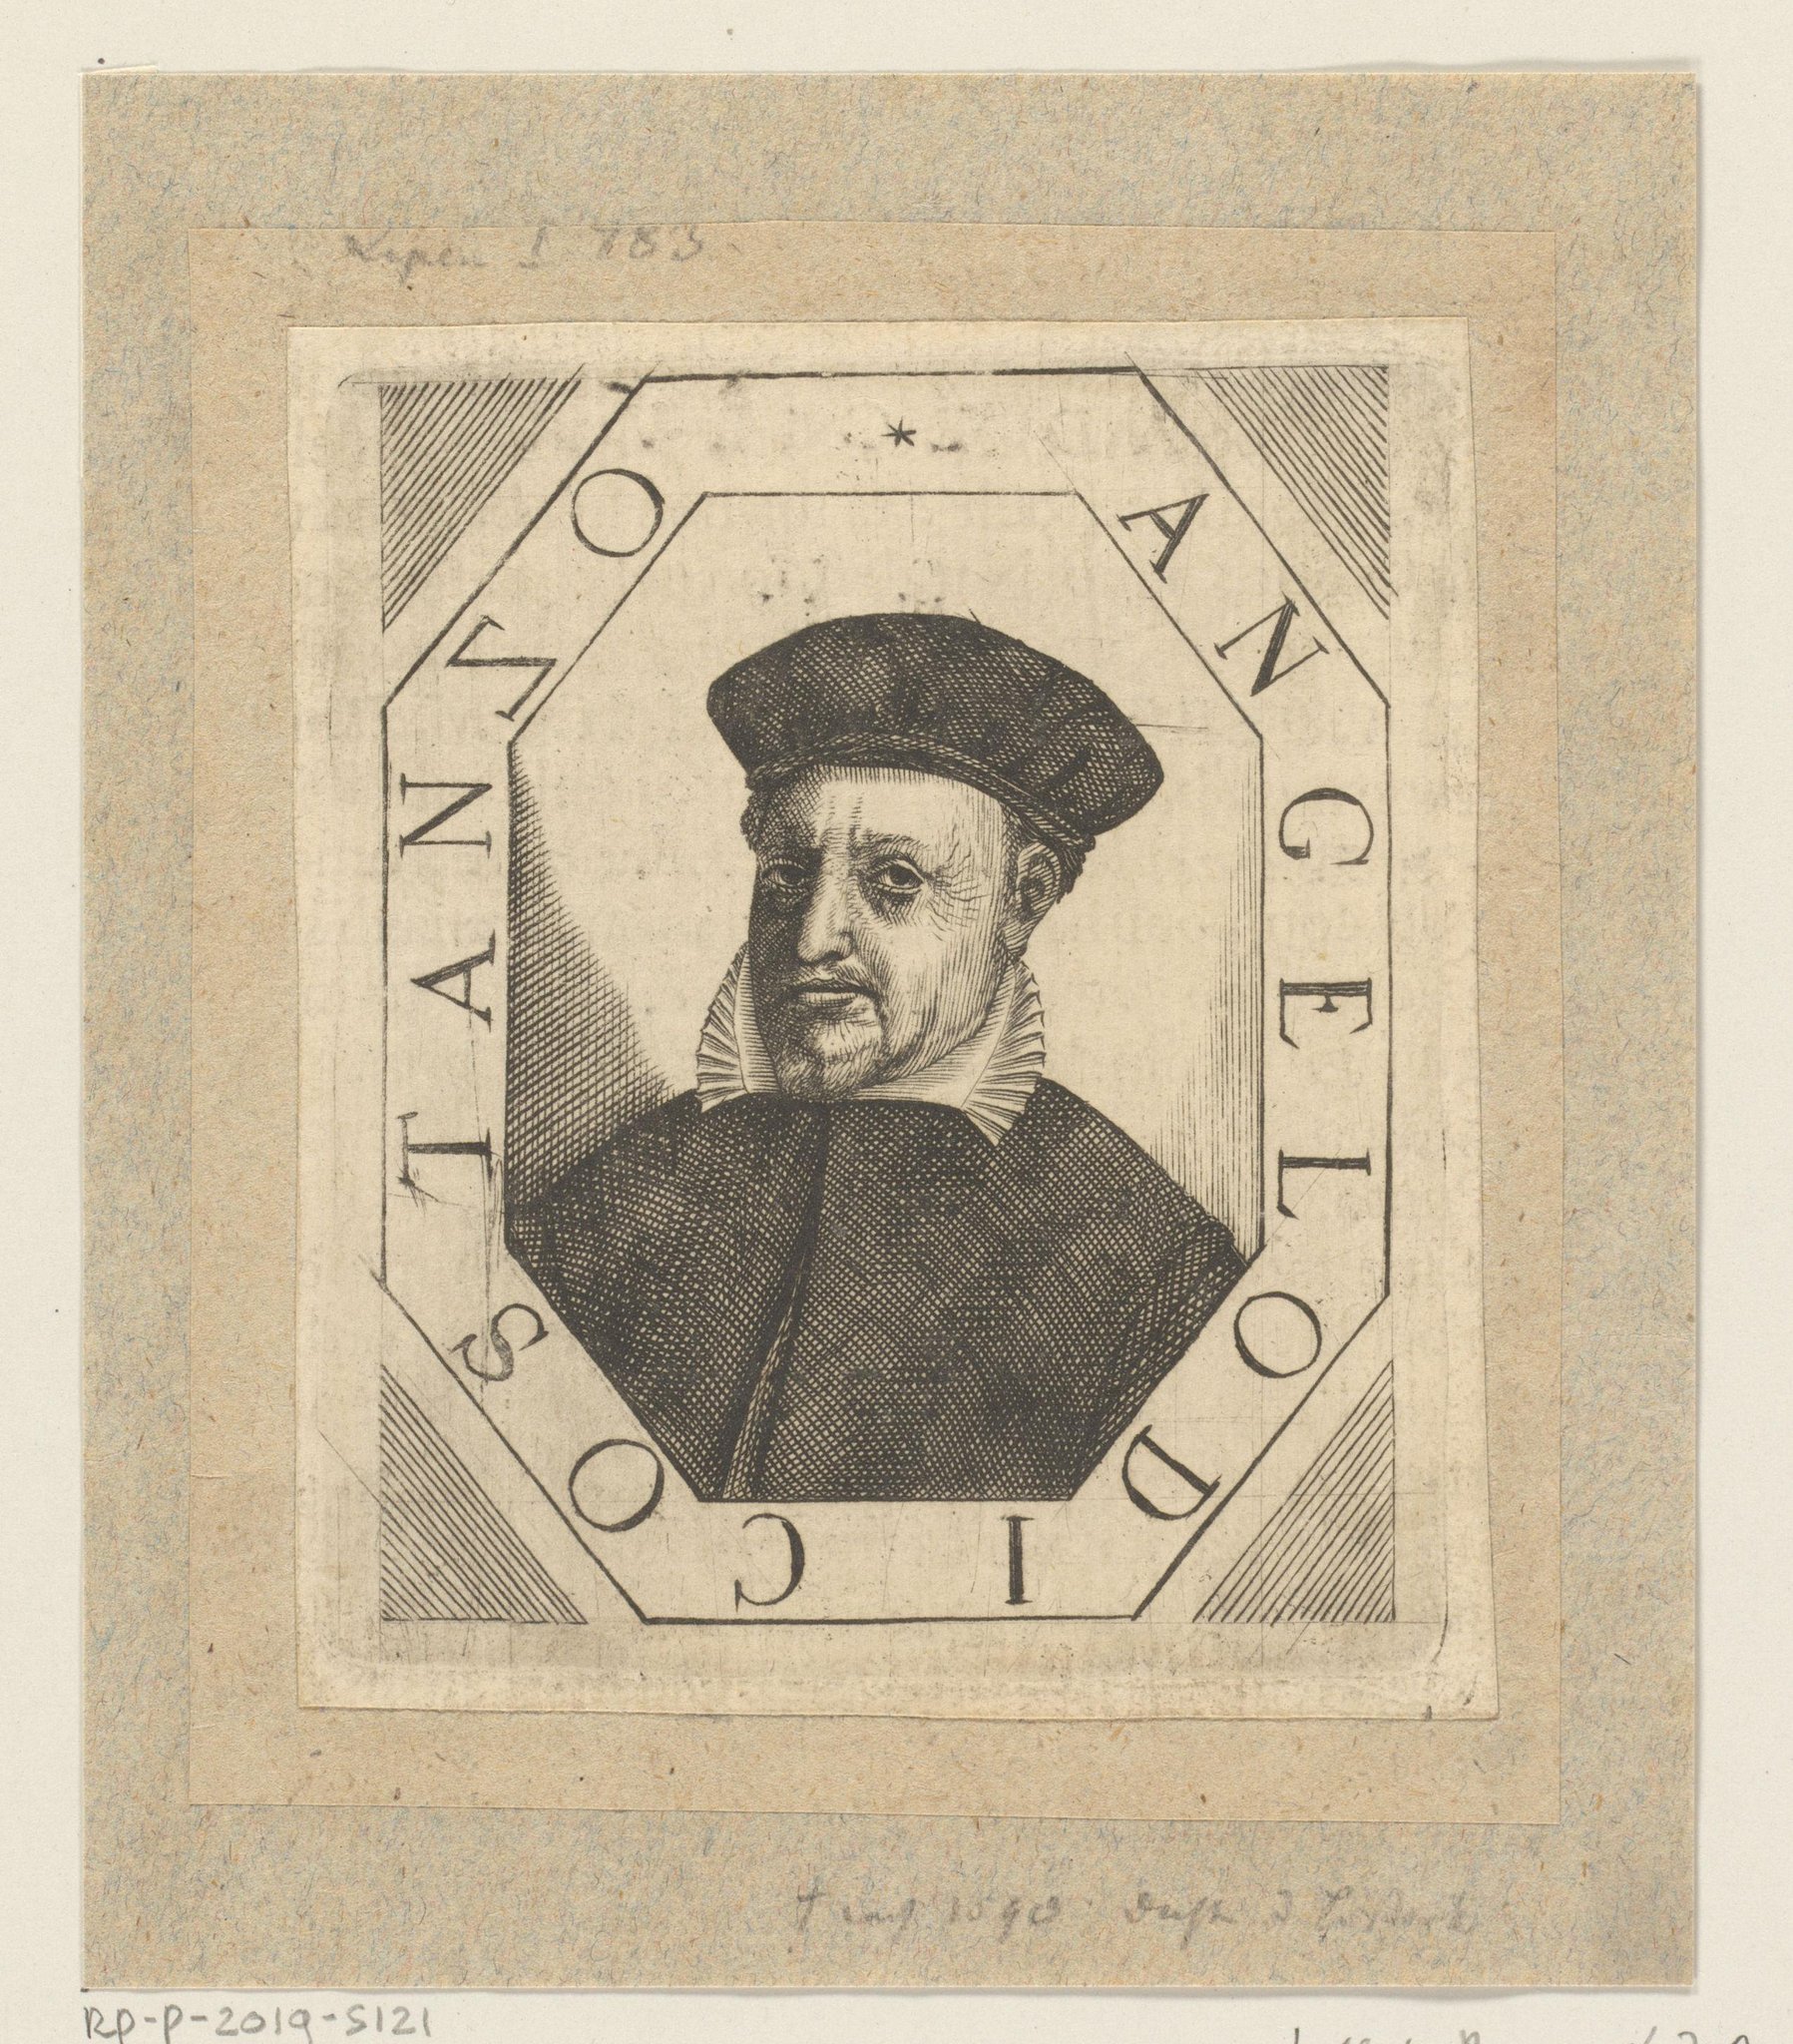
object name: book illustration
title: Portret van dichter Angelo di Costanzo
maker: Anonymous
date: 1666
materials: paper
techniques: engraving, letterpress printing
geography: venice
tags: naples, historical persons, portrait of a writer, writer, poet, author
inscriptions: inscription: ‘[...]’, inscription: ‘[...] 183’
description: Prent uit: Crasso, Lorenzo. Elogii degli huomini letterati scritti. Venetië: Combi & la Noù, 1666, dl. 2, p. 50.